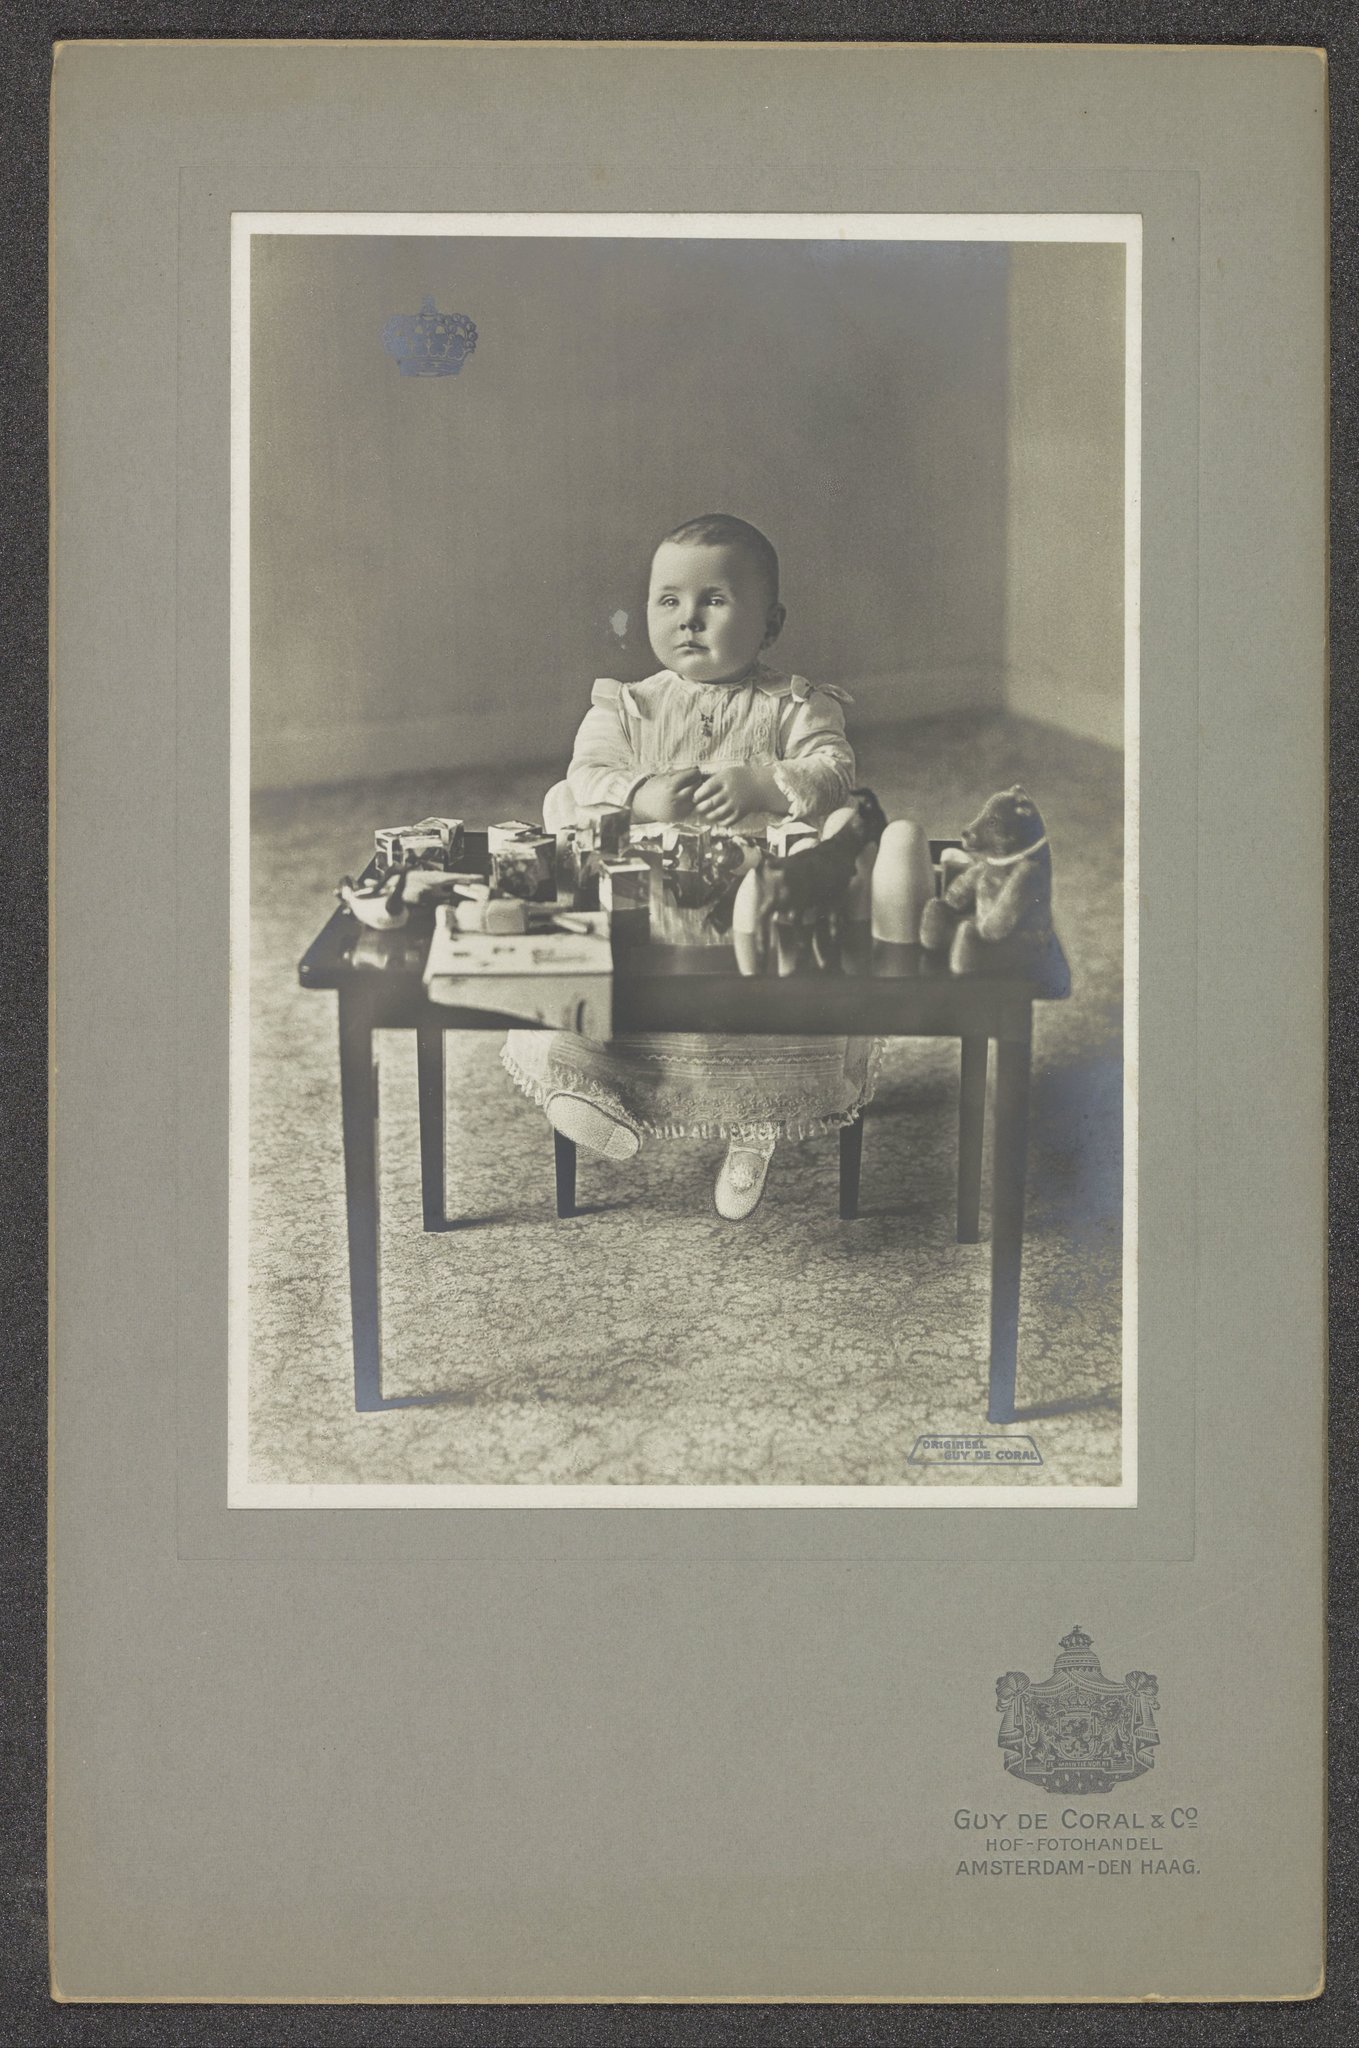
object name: photograph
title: Portret van koningin Juliana als baby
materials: photographic support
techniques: gelatin silver print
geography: the hague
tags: juliana of the netherlands, the hague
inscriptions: stamp: ‘Guy de Coral & Co hof-fotohandel Amsterdam - Den Haag’